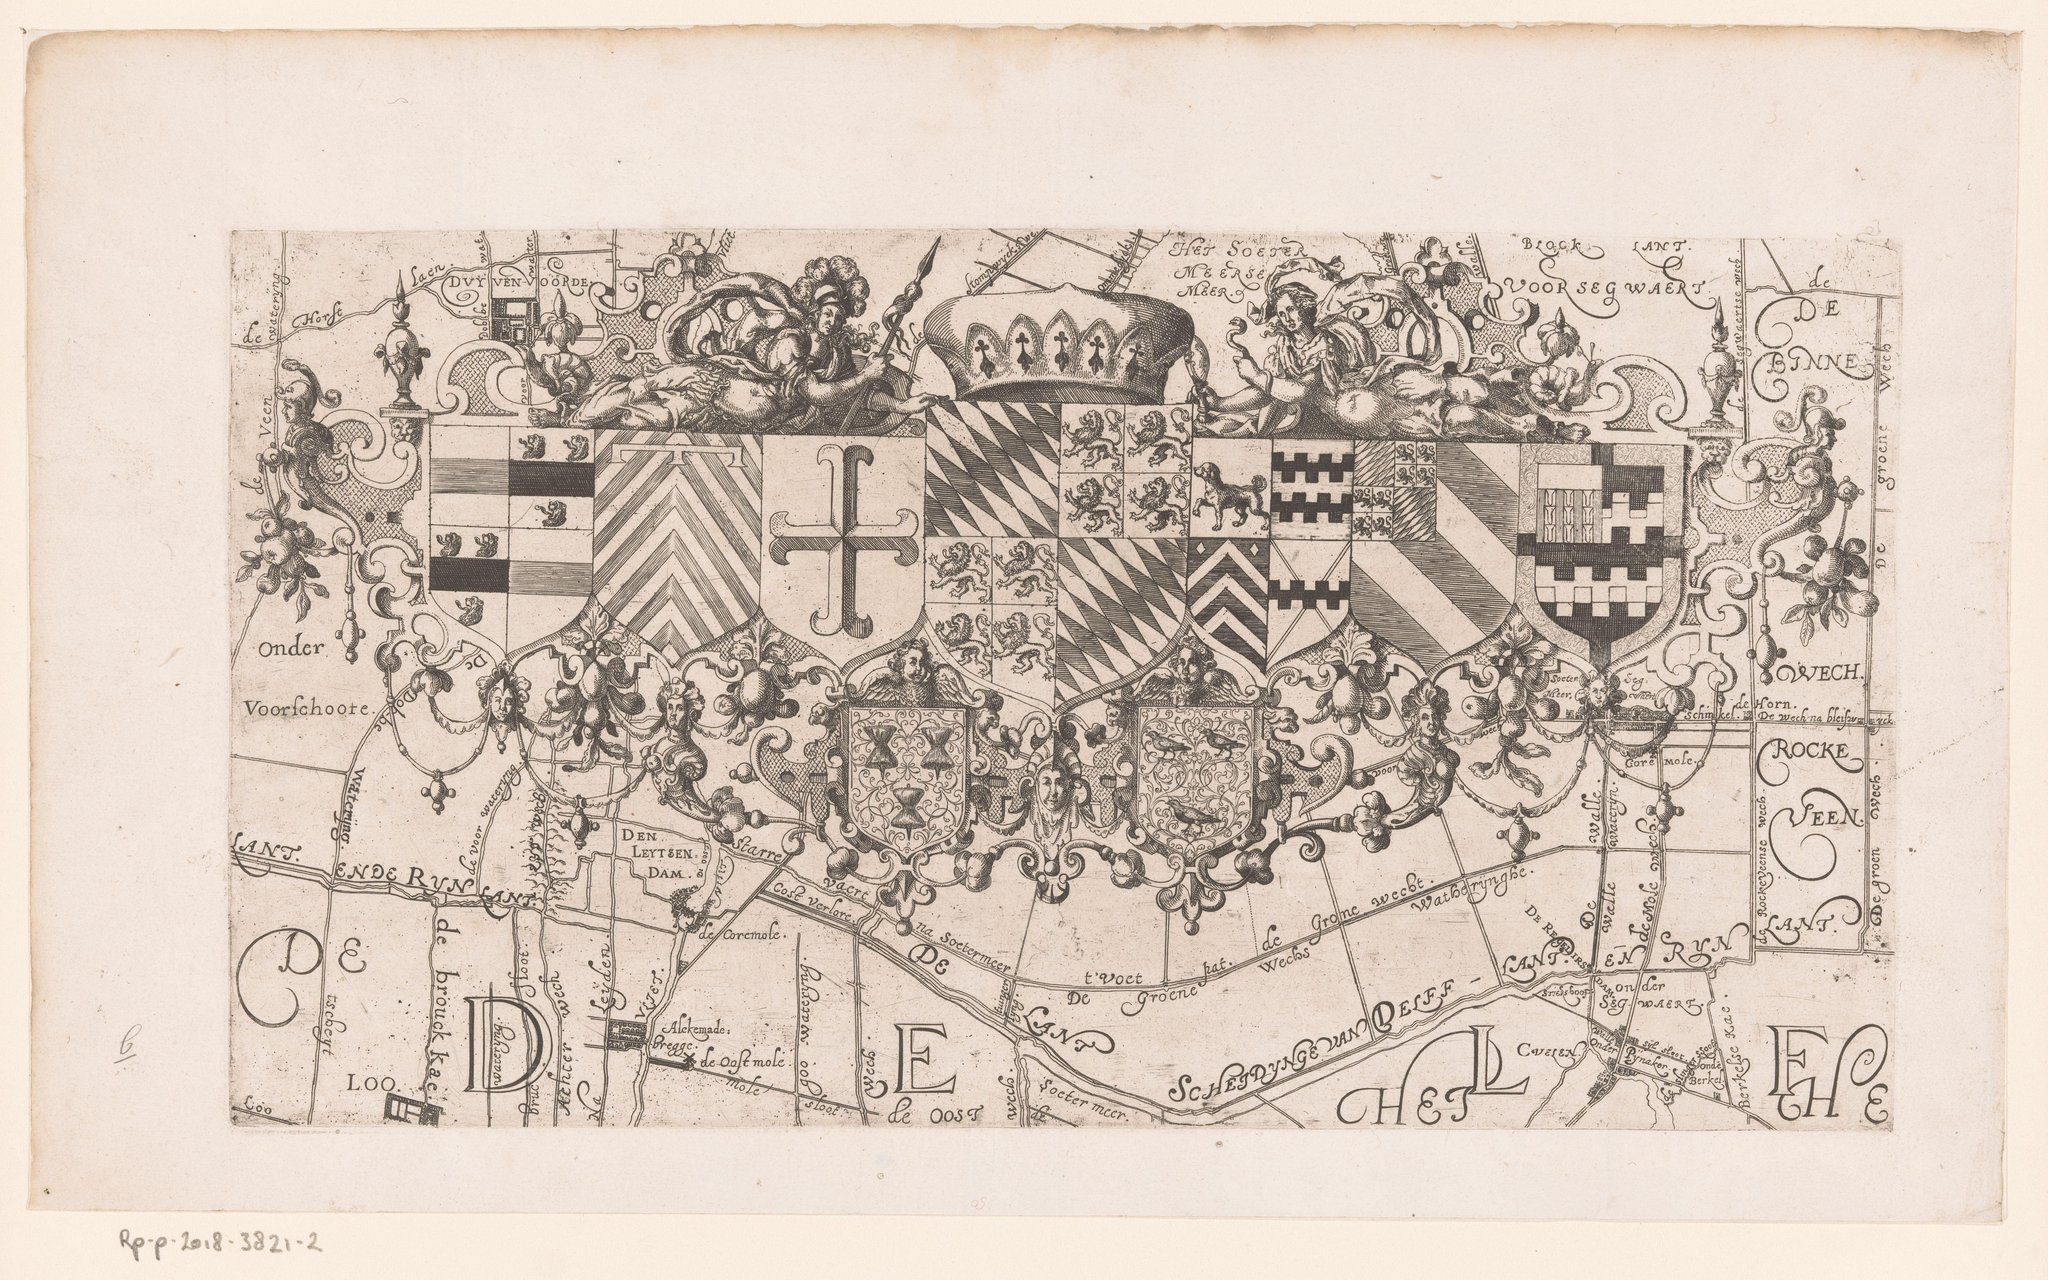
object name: print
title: Kaart van het Hoogheemraadschap van Delfland, deel midden boven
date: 1611-1692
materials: paper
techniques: engraving, etching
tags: maps of separate countries or regions, armorial bearing, heraldry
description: Met de wapens van de leden van het Hoogheemraadschap van Rijnland.